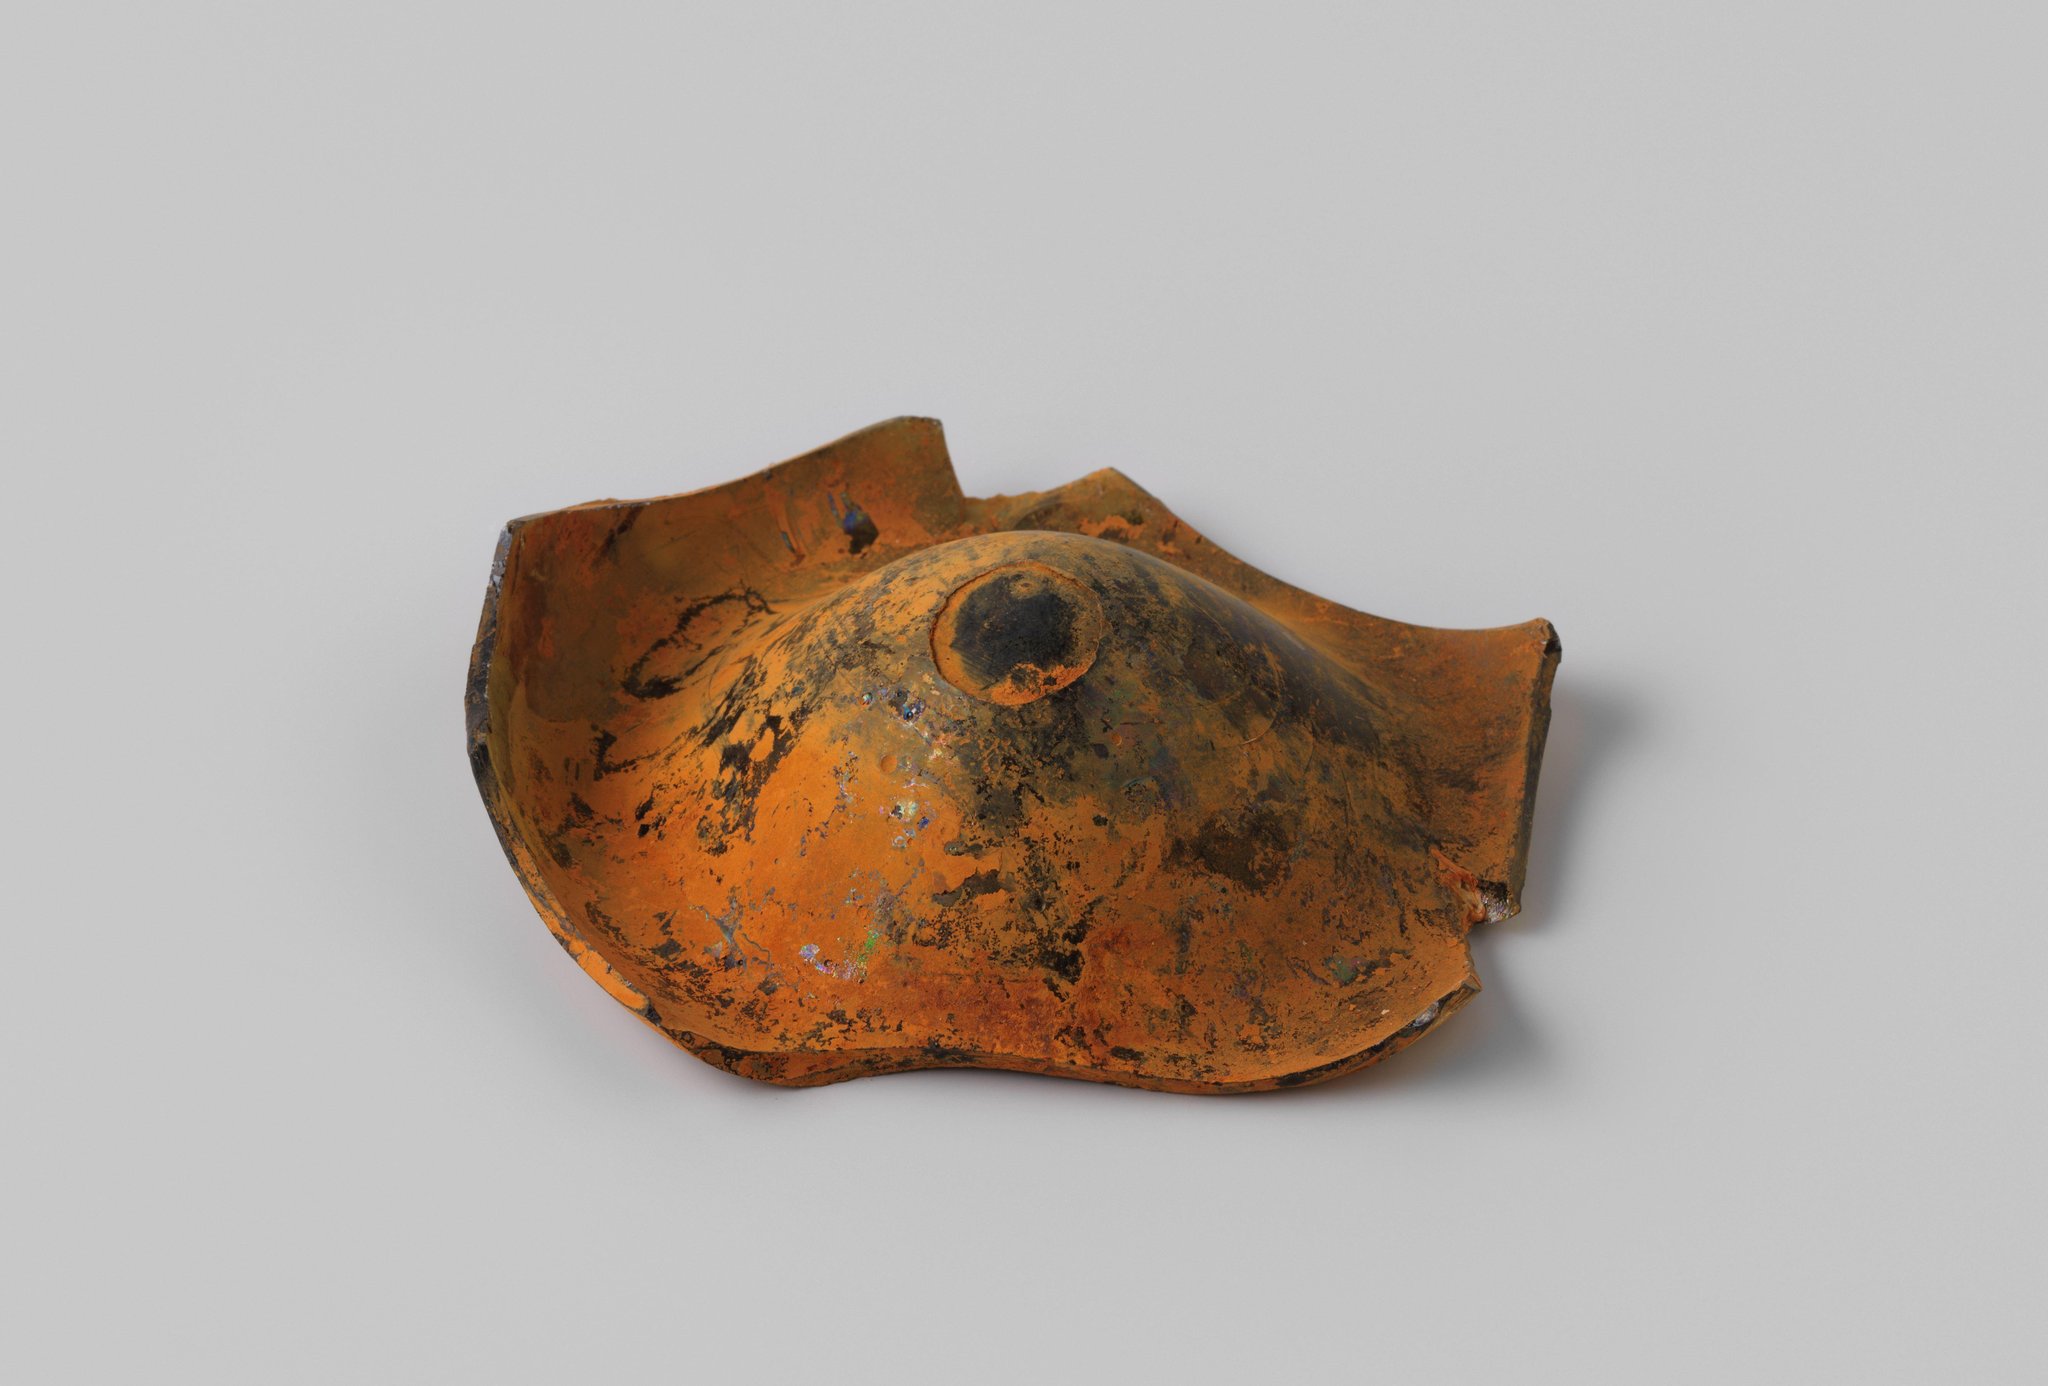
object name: sherd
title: Bodemfragment wijnfles uit het wrak van de Oost-Indiëvaarder Hollandia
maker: Anonymous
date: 1700-1743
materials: glass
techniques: green glass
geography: netherlands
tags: verenigde oostindische compagnie, hollandia (schip), annet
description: Onion-shaped bottle or bottle with vertical side, base, cs-kick-up. Continental production.